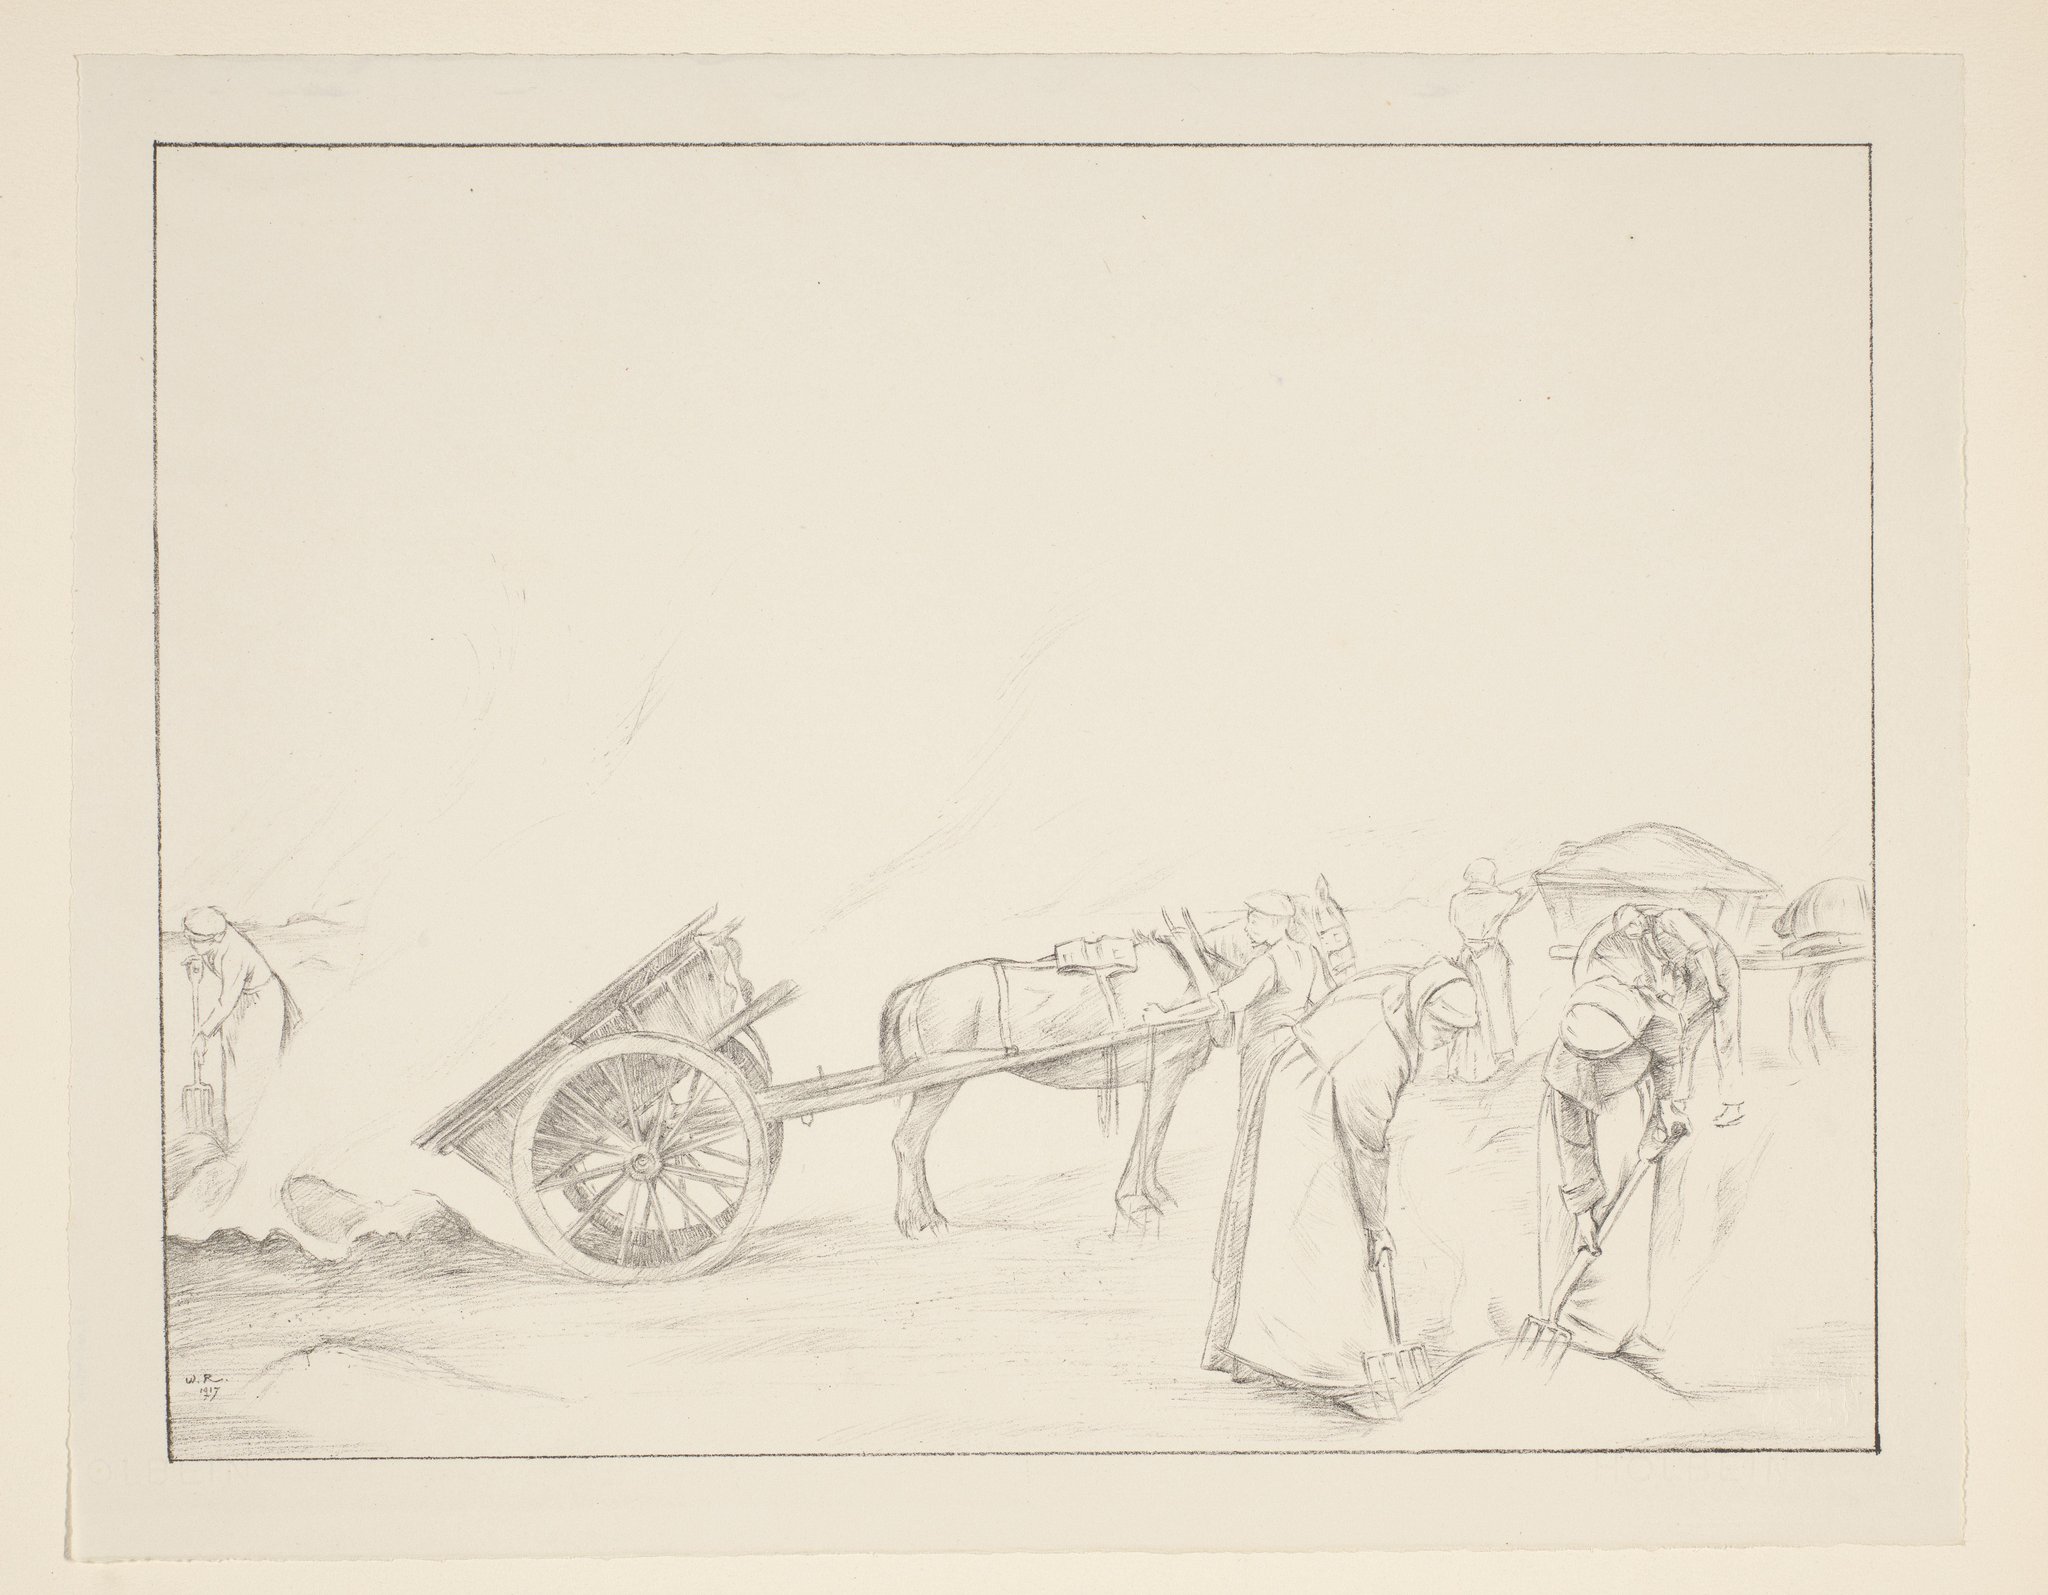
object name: print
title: Burning couch-grass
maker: william rothenstein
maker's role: print maker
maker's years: 1872-1945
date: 1917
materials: paper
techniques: lithograph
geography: england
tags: farmers - aa - female farmer, farmer's wife, soil cultivation, potatoes, agriculture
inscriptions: watermark, watermark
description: Deze prent behoort tot de reeks 'Work on the Land' binnen de serie 'The Great War: Britain’s Efforts and Ideals'.